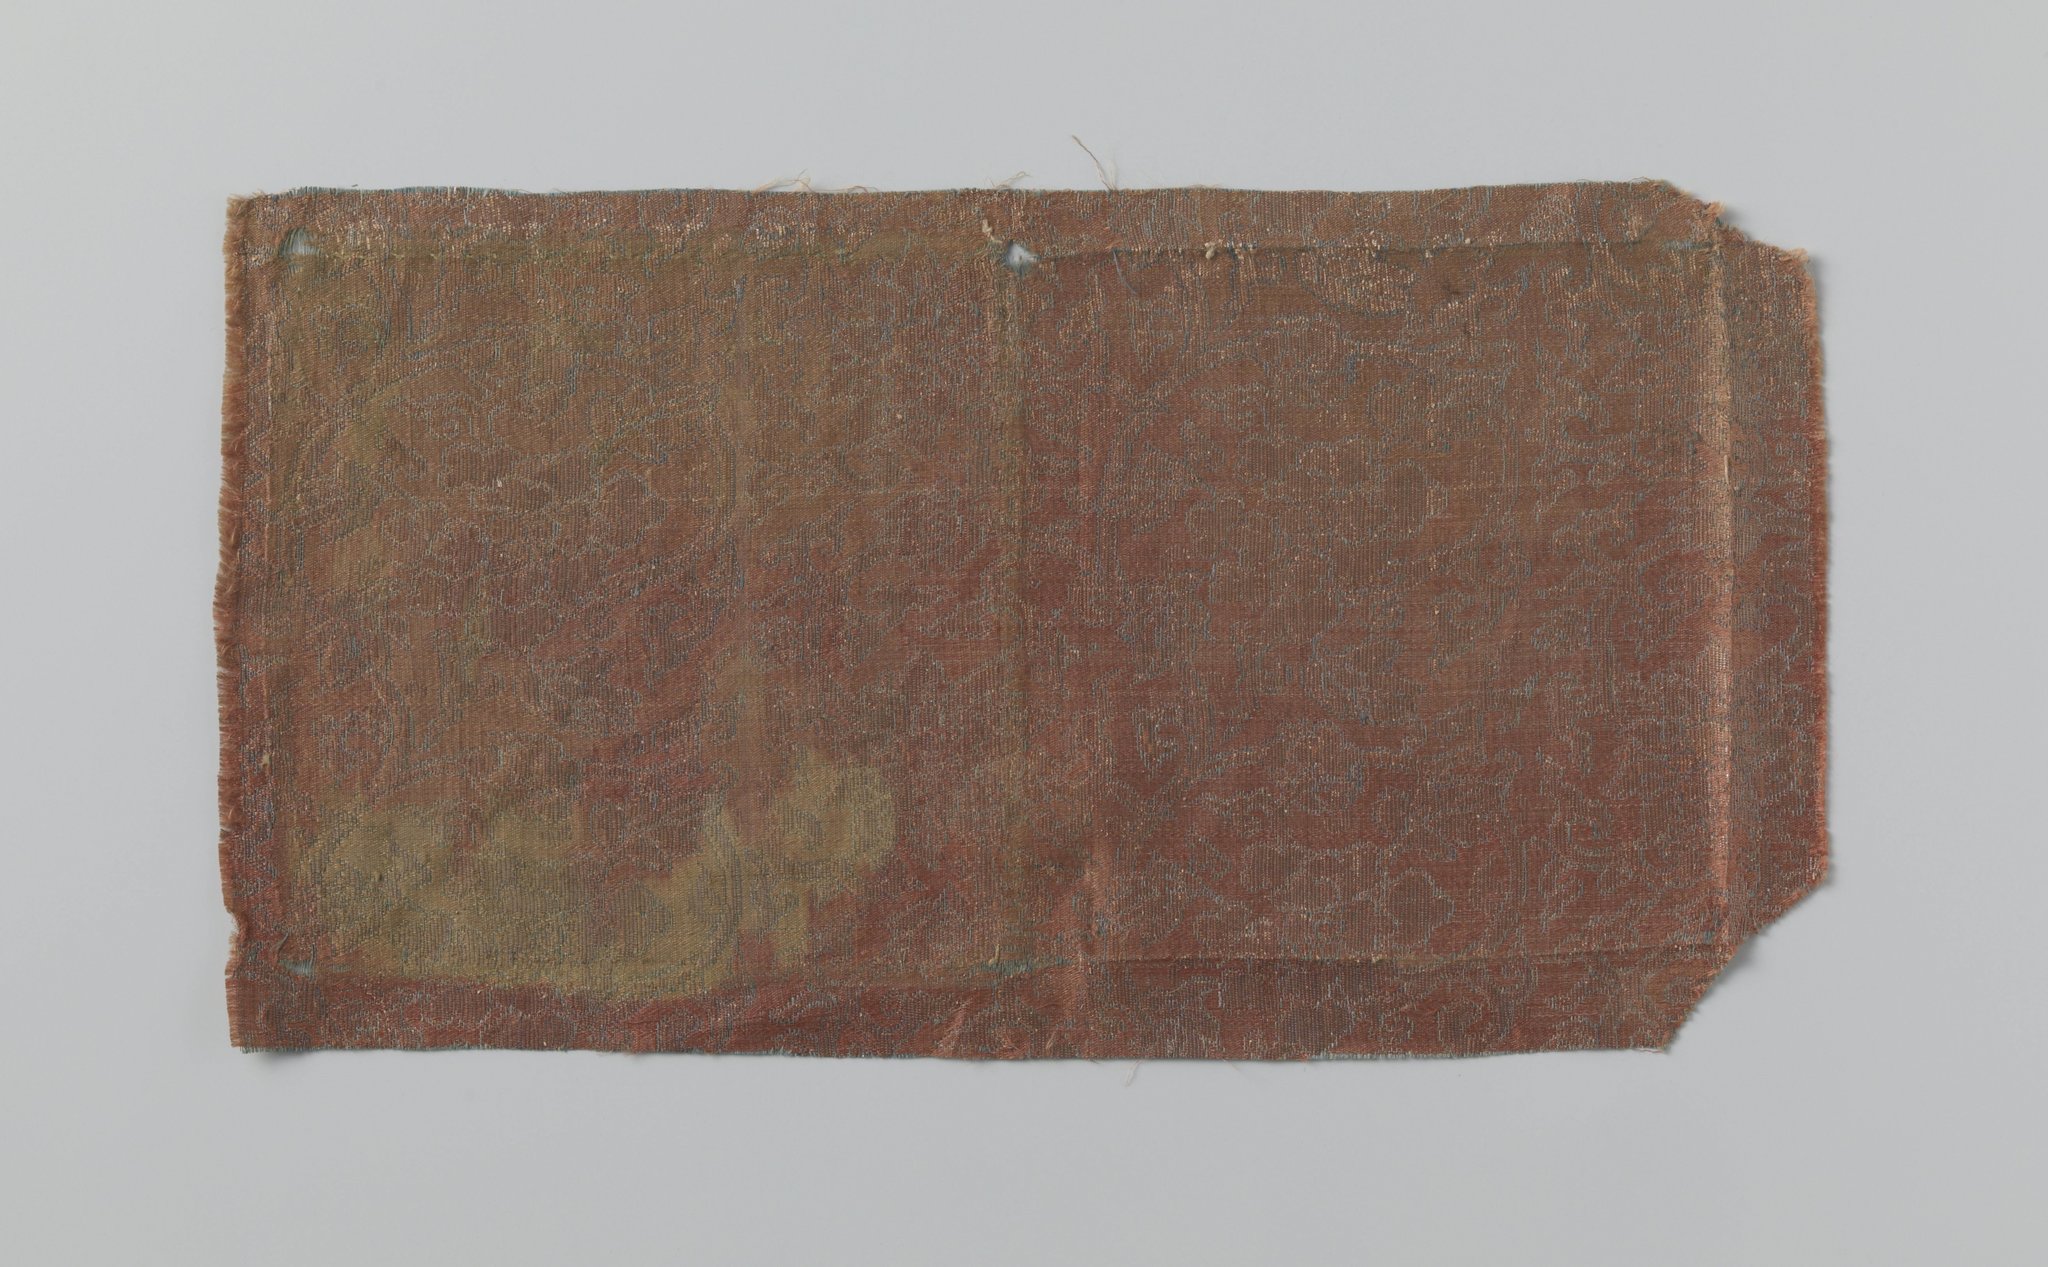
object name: zijdesatijn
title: Fragment rode zijdesatijn met floraal motief in zilverlamel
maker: Anonymous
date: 1600-1699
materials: silk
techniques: brocade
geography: iran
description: Fragment rode zijde met zilverkleurig ornament met blauwe omtrek van slingerende takken met bloemen en bladeren.